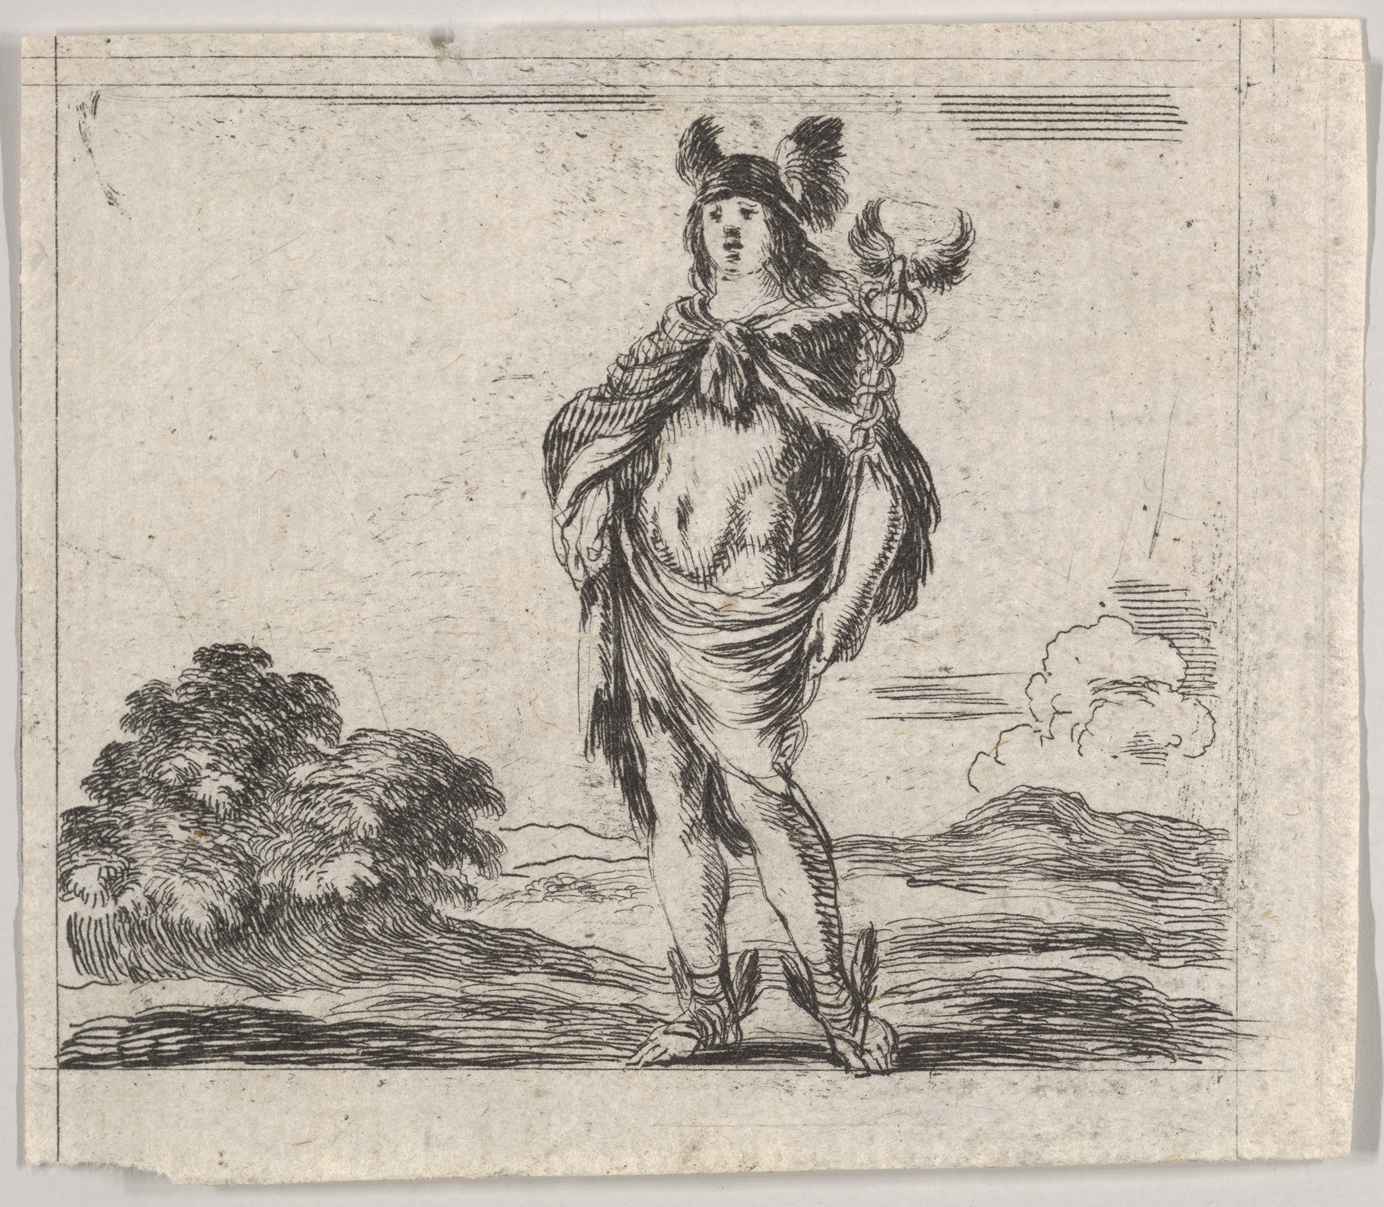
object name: print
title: Mercury, from "Game of Mythology" (Jeu de la Mythologie)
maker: stefano della bella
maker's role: artist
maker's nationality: italian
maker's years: 1610-1664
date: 1644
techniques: etching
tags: mercury